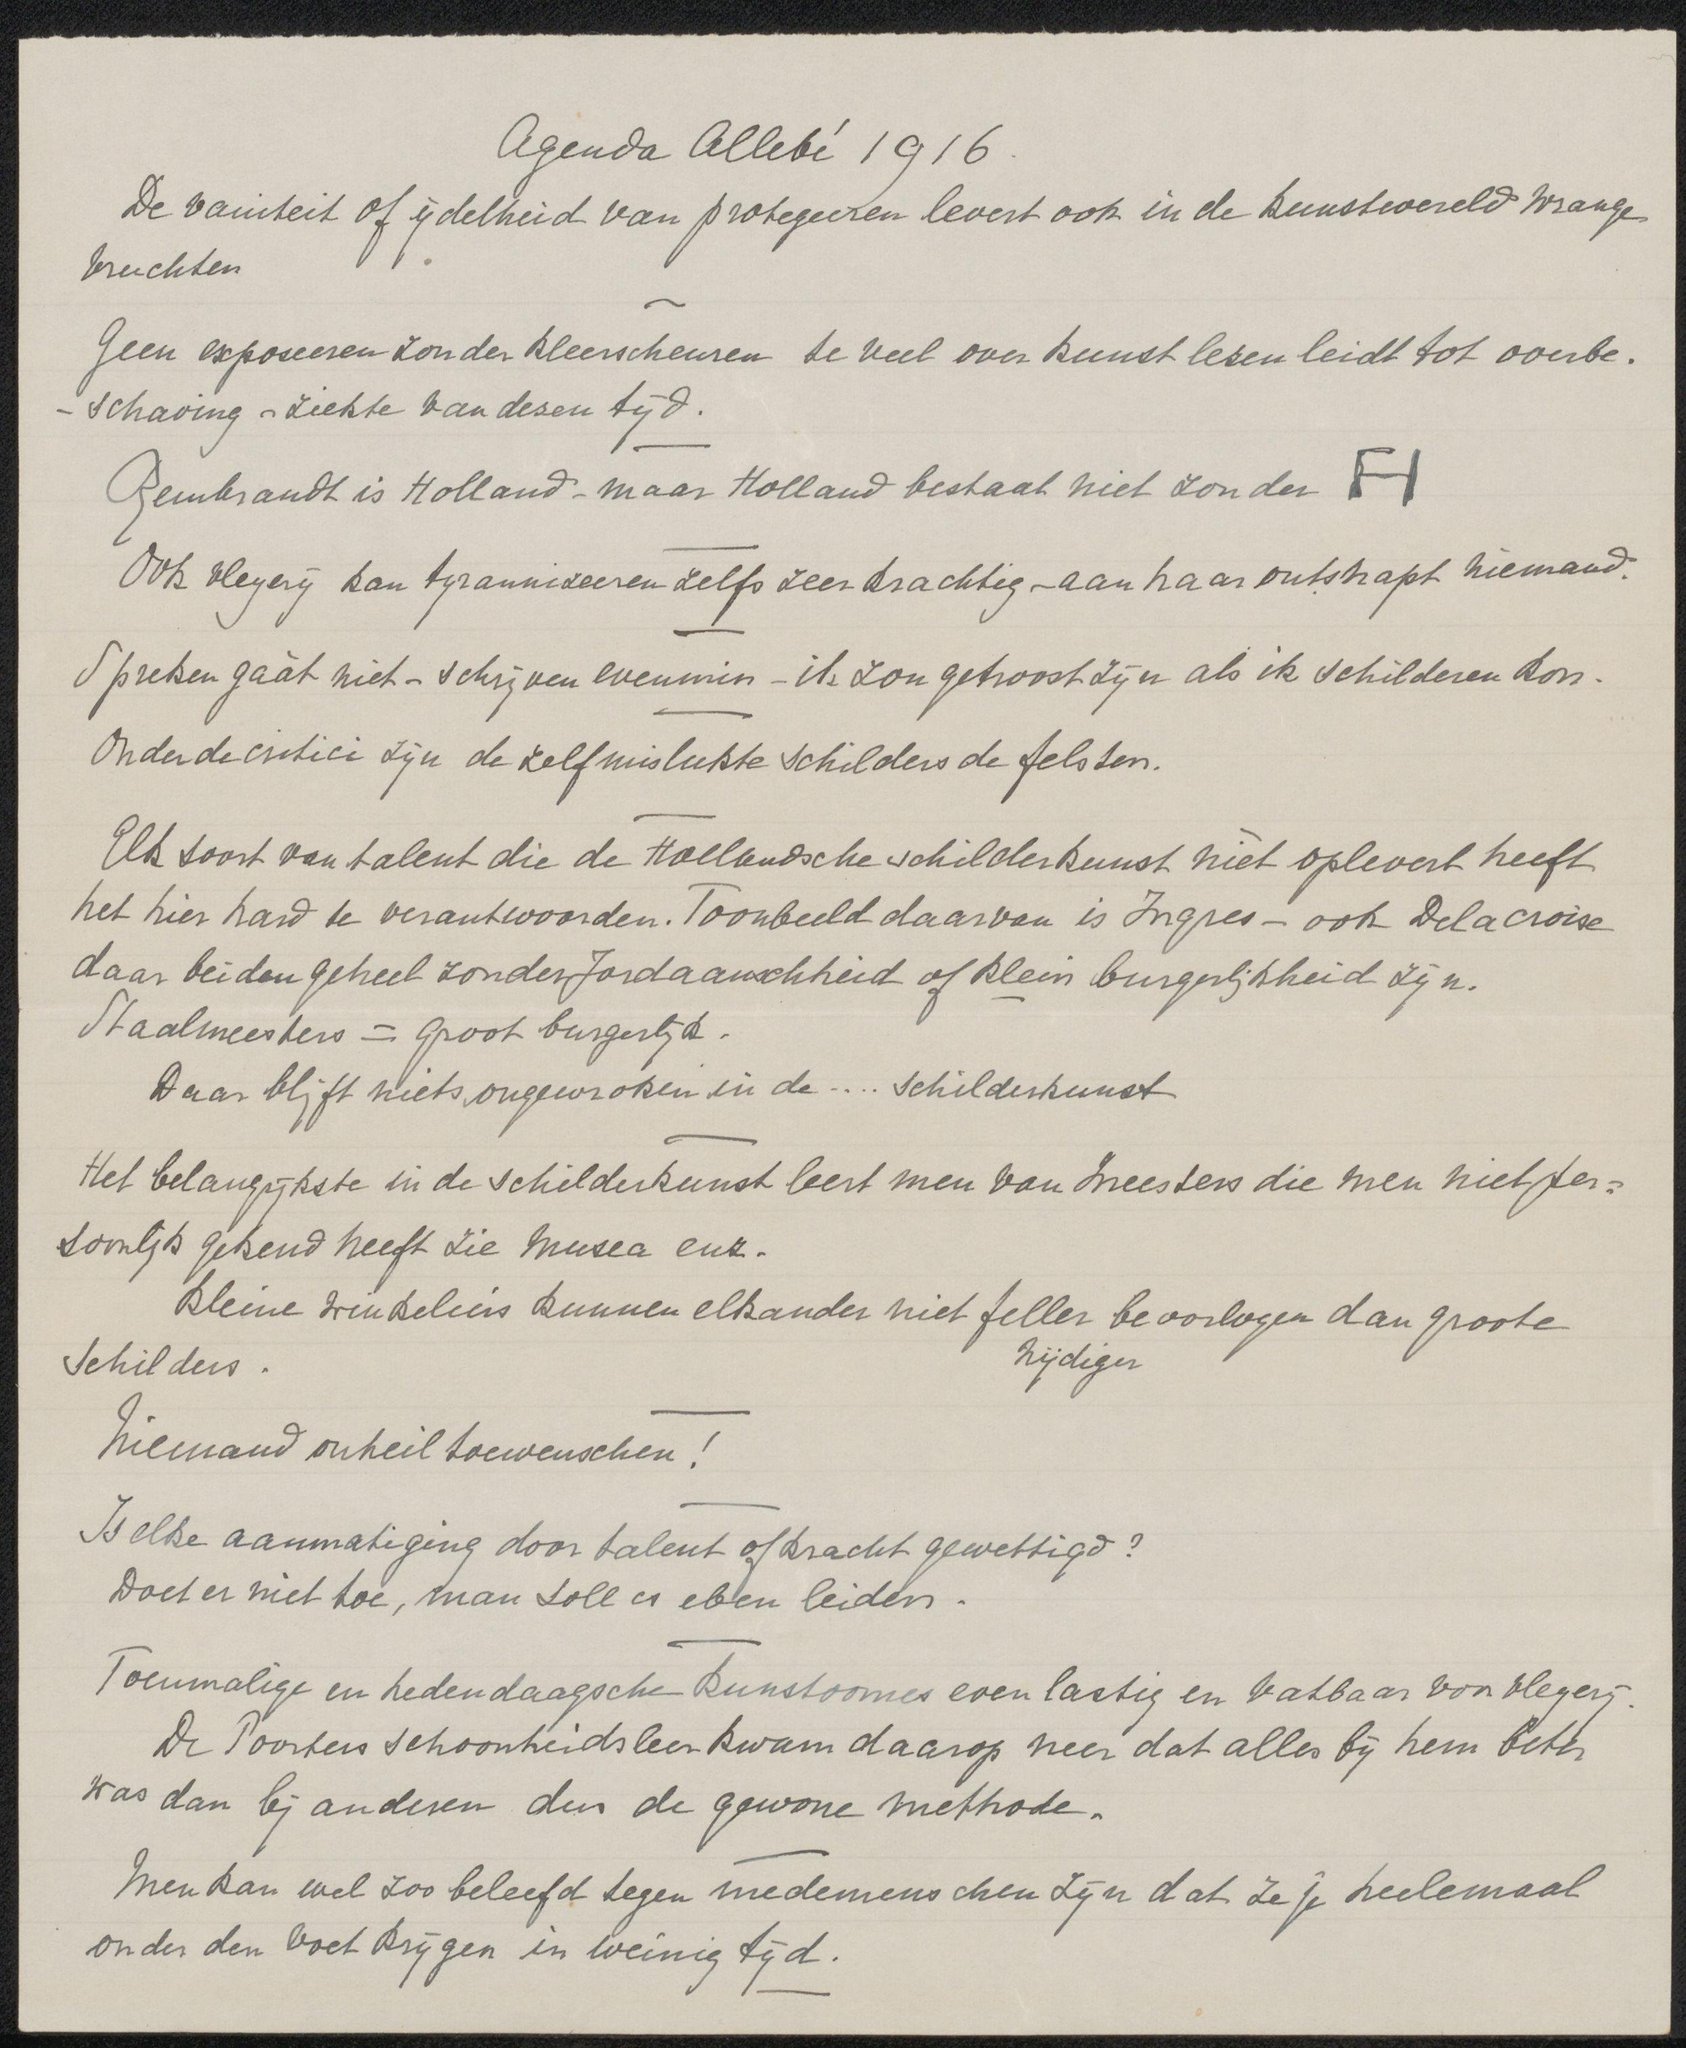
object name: tekst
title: Tekst uit collectie August Allebé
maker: pieter gerbrand van tienhoven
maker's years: 1875-1953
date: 1916-1953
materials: ink, paper, pencil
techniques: pen, writing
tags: painting (including book-illumination, miniature-painting)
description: Aantekeningen uit de agenda's van 1916 van August Allebé, overgeschreven door Pieter Gerbrand van Tienhoven.